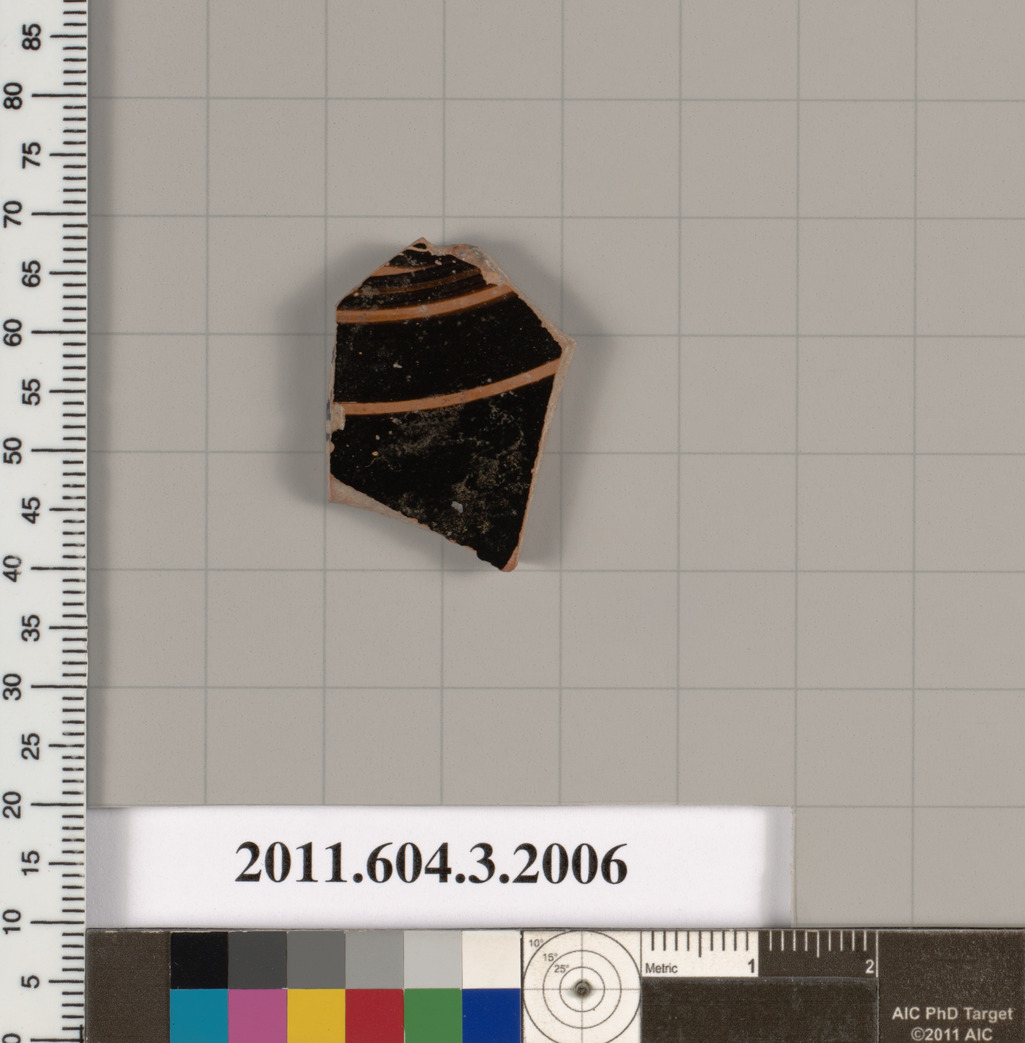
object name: kylix fragment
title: Terracotta fragment of a kylix (drinking cup)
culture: greek, attic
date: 550-526 BCE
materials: terracotta